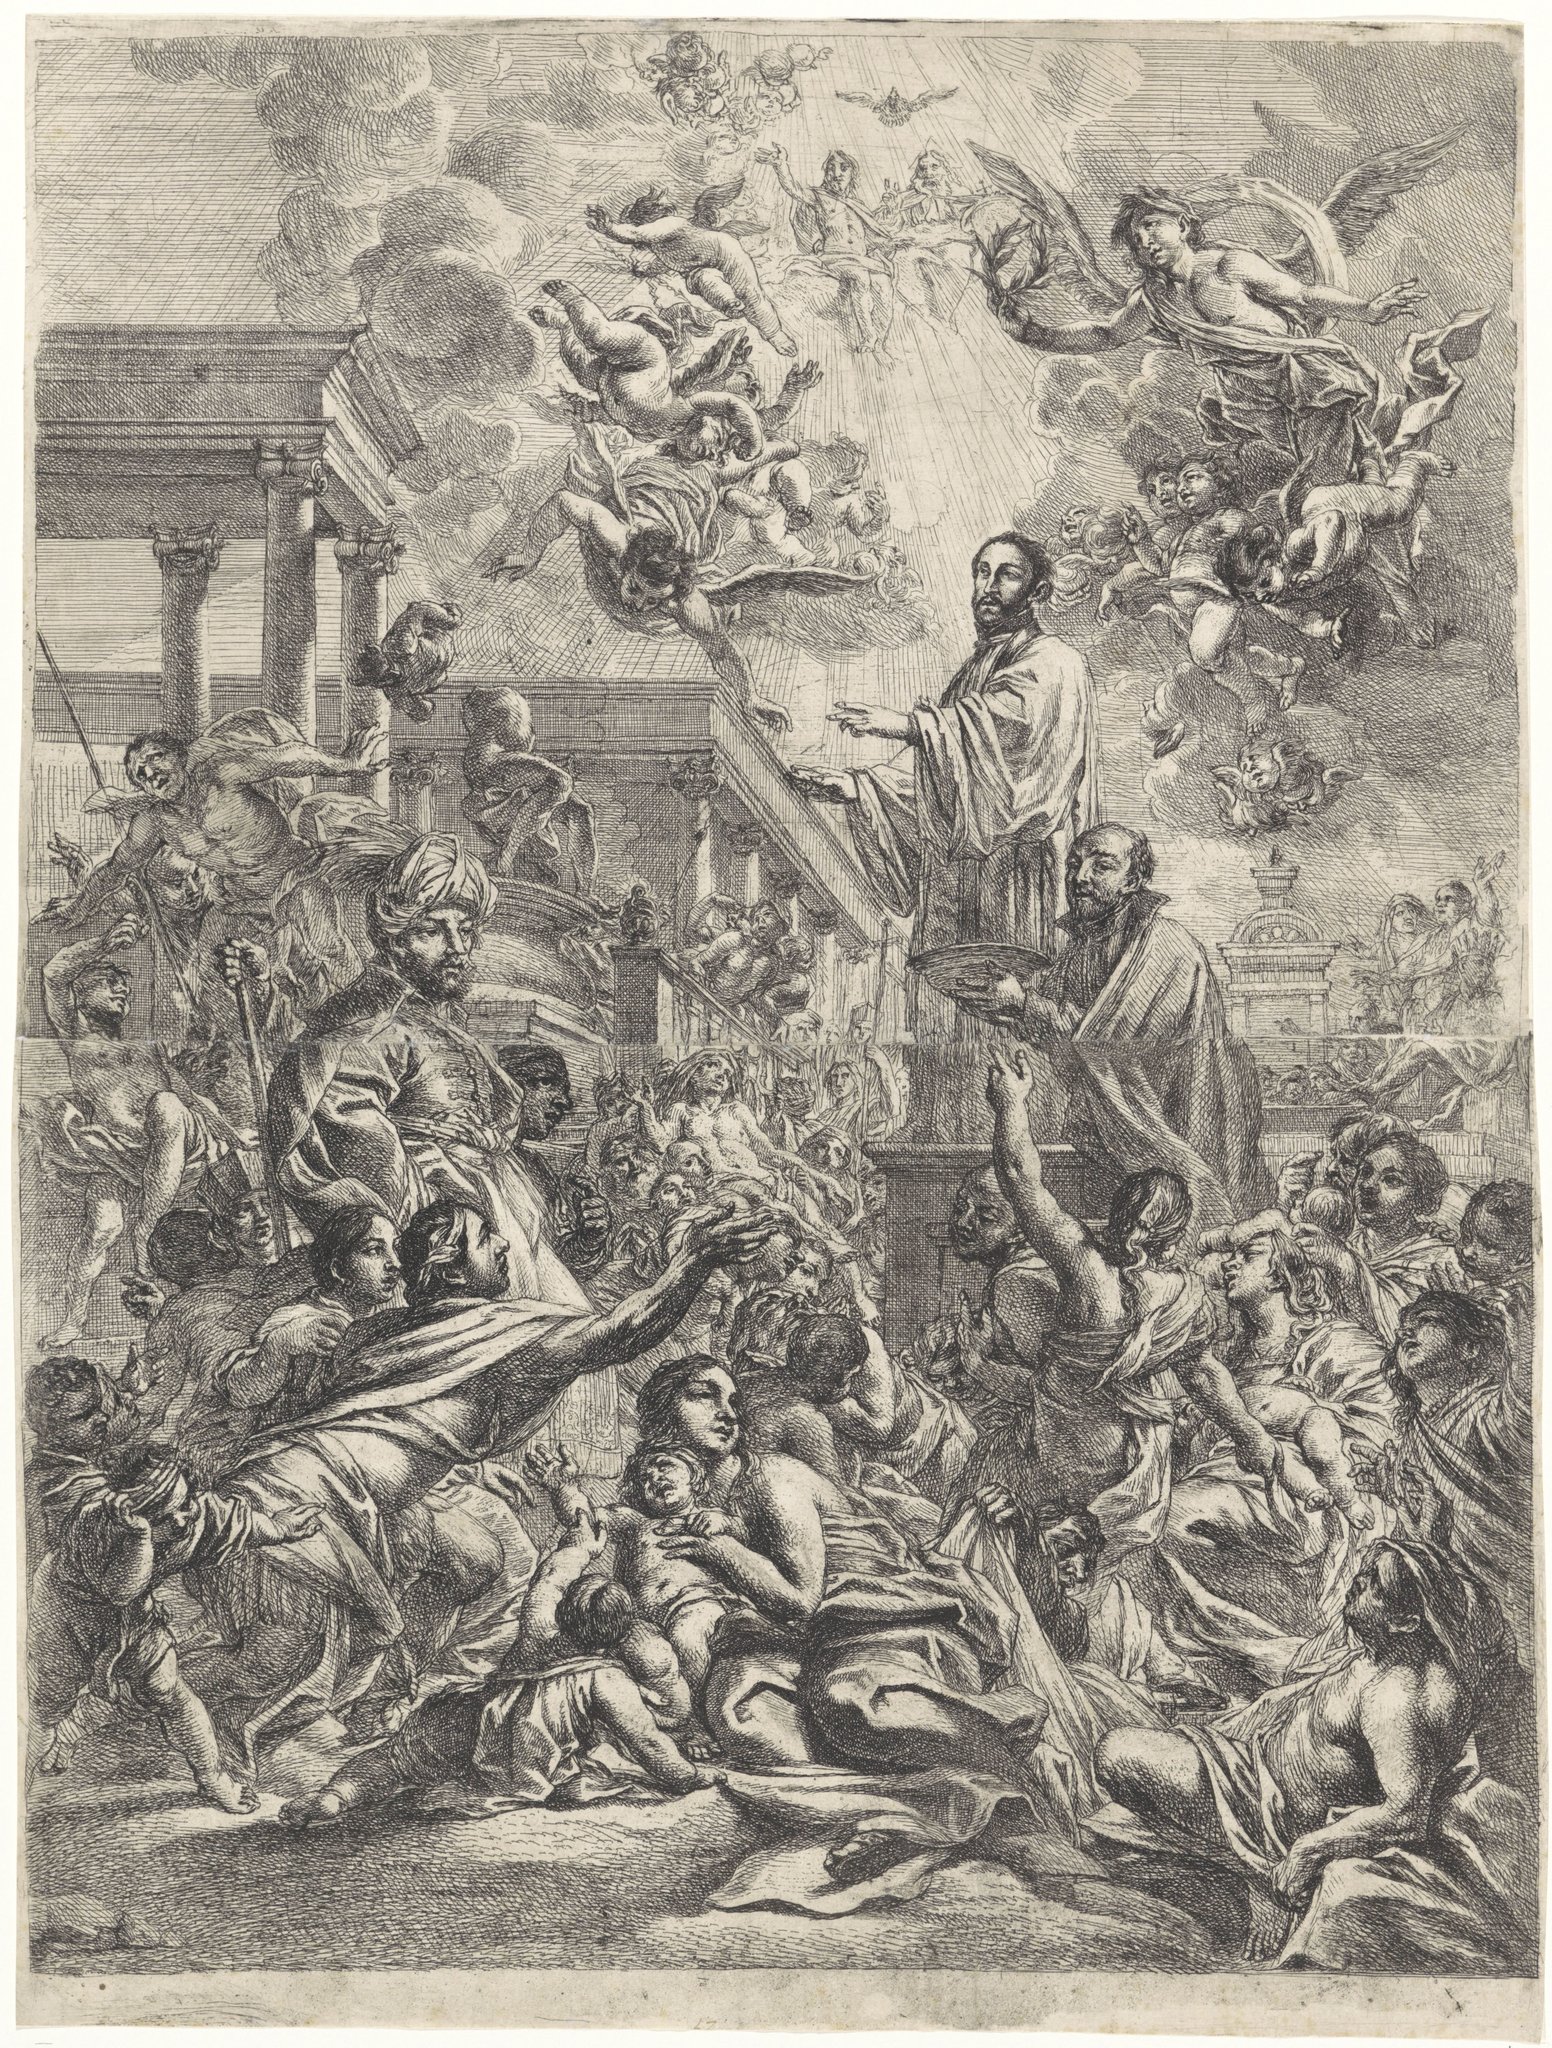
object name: print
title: H. Ignatius van Loyola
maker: cornelis schut (i)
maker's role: draughtsman, print maker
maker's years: 1597-1655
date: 1618-1655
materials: paper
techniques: engraving, etching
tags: clergyman, cupids: 'amores', 'amoretti', 'putti', angels, trinity as three persons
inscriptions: collector's mark: Lugt 240, collector's mark: Lugt 2228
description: De heilige Ignatius van Loyola staat prekend op een marktplein. Mannen, vrouwen en kinderen werpen zich aan zijn voeten. Engelen en putti dalen neer uit de hemel. Bovenaan de heilige Drievuldigheid. Gedrukt van twee platen.